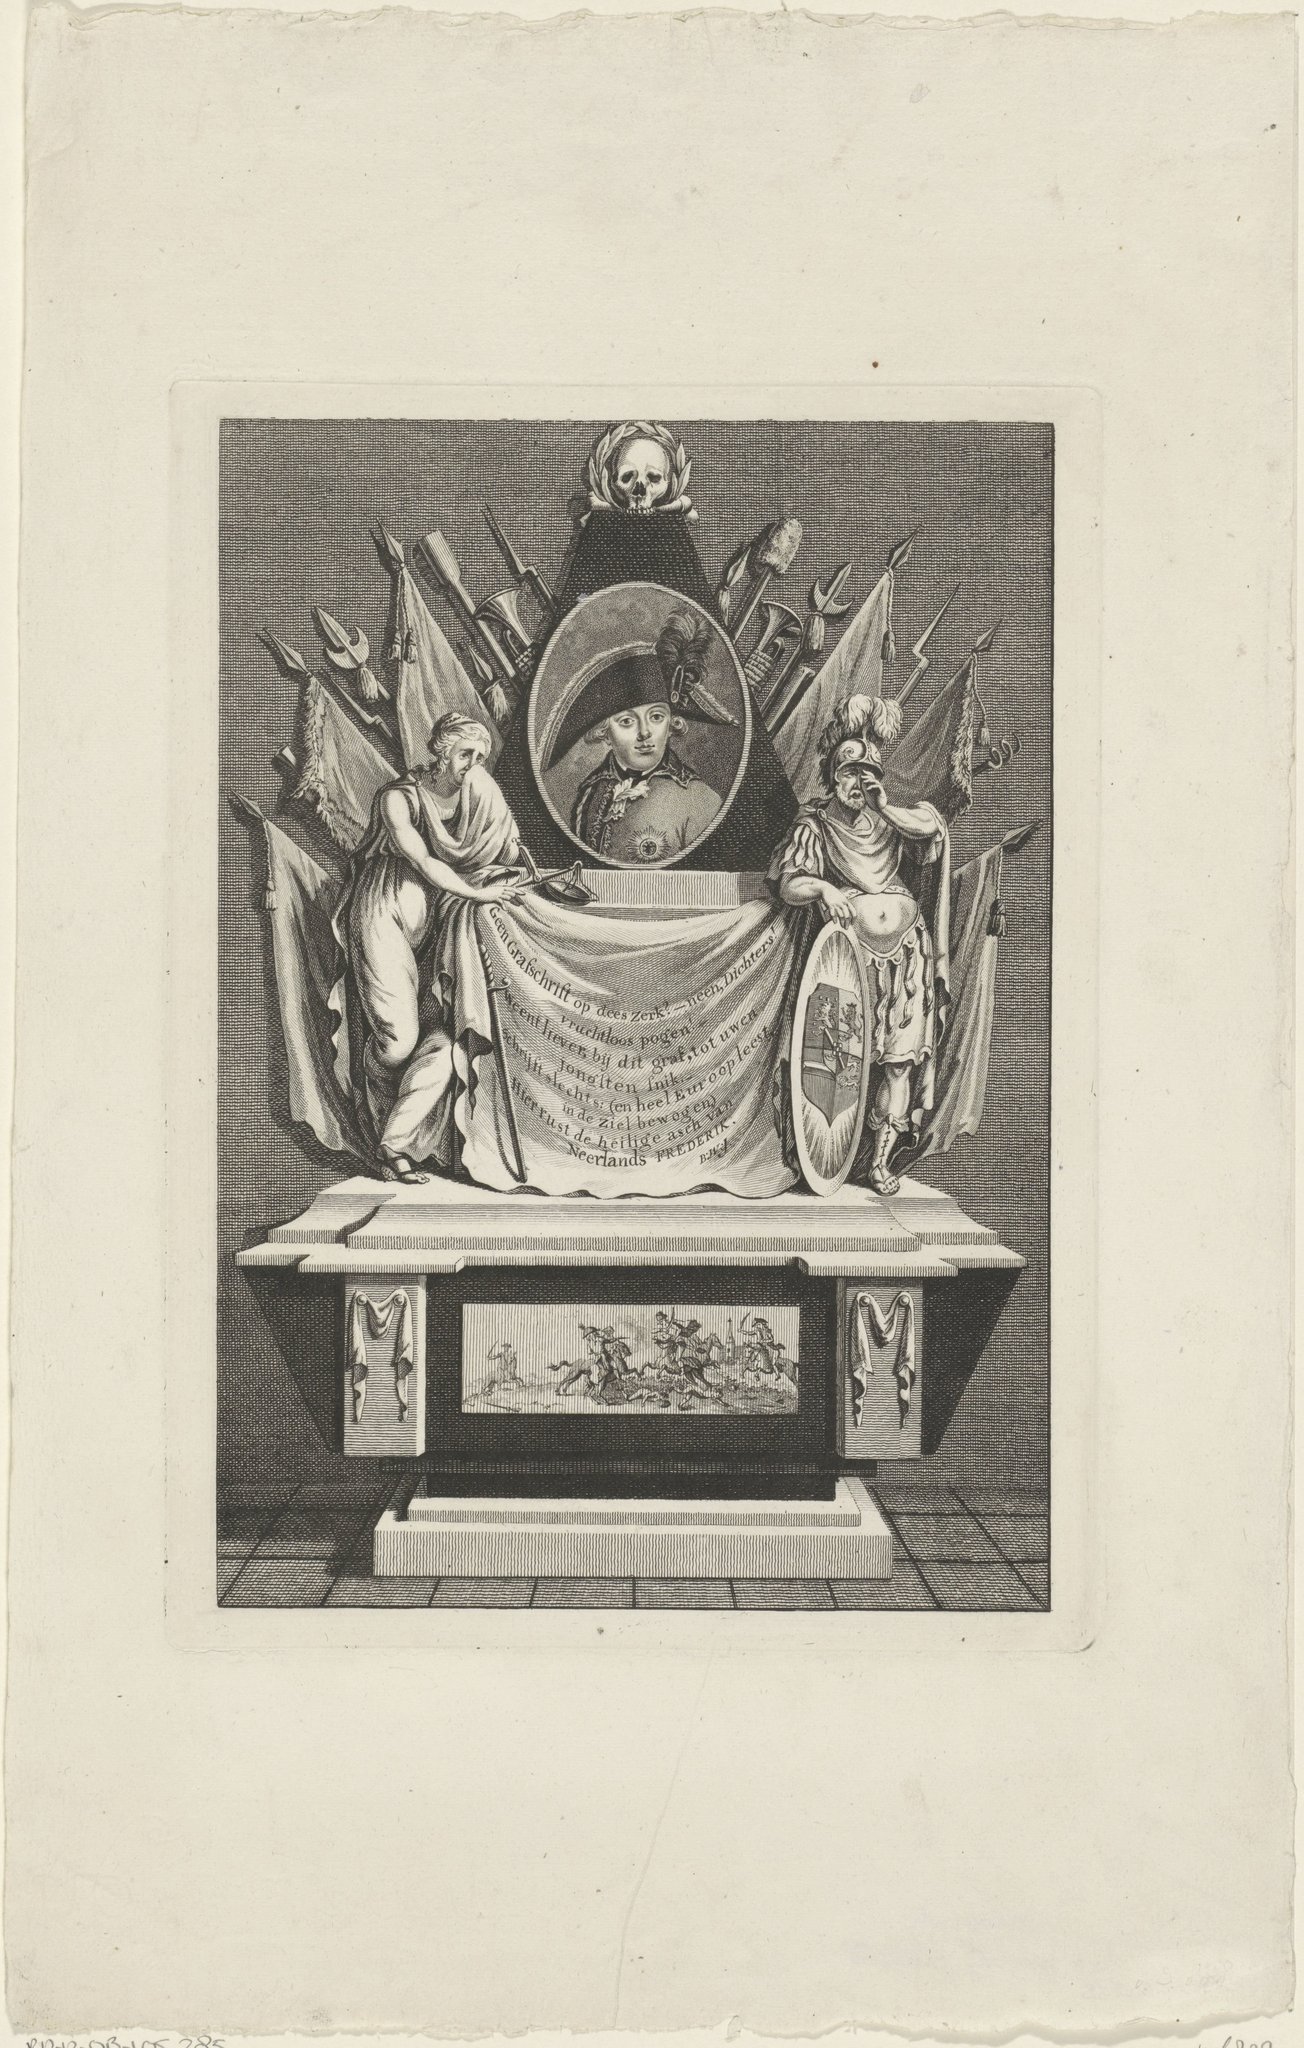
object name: print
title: Allegorisch grafmonument voor Frederik, prins van Oranje-Nassau, 1799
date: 1799-1801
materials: paper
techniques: engraving, etching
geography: low countries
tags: the hague, willem george frederik (prins van oranje-nassau), knighthood order (with name) - insignia of a knighthood order, e.g.: badge, chain (with name of order), grave-building, monumental tomb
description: Allegorisch grafmonument voor Frederik, overleden te Padua op 6 januari 1799. Portret van Frederik in een ovaal. Daar omheen een aantal allegorische objecten en een treurende Gerechtigheid en Mars. Op het reliëf een voorstelling van een veldslag. Op een doek acht regels Nederlandse tekst.